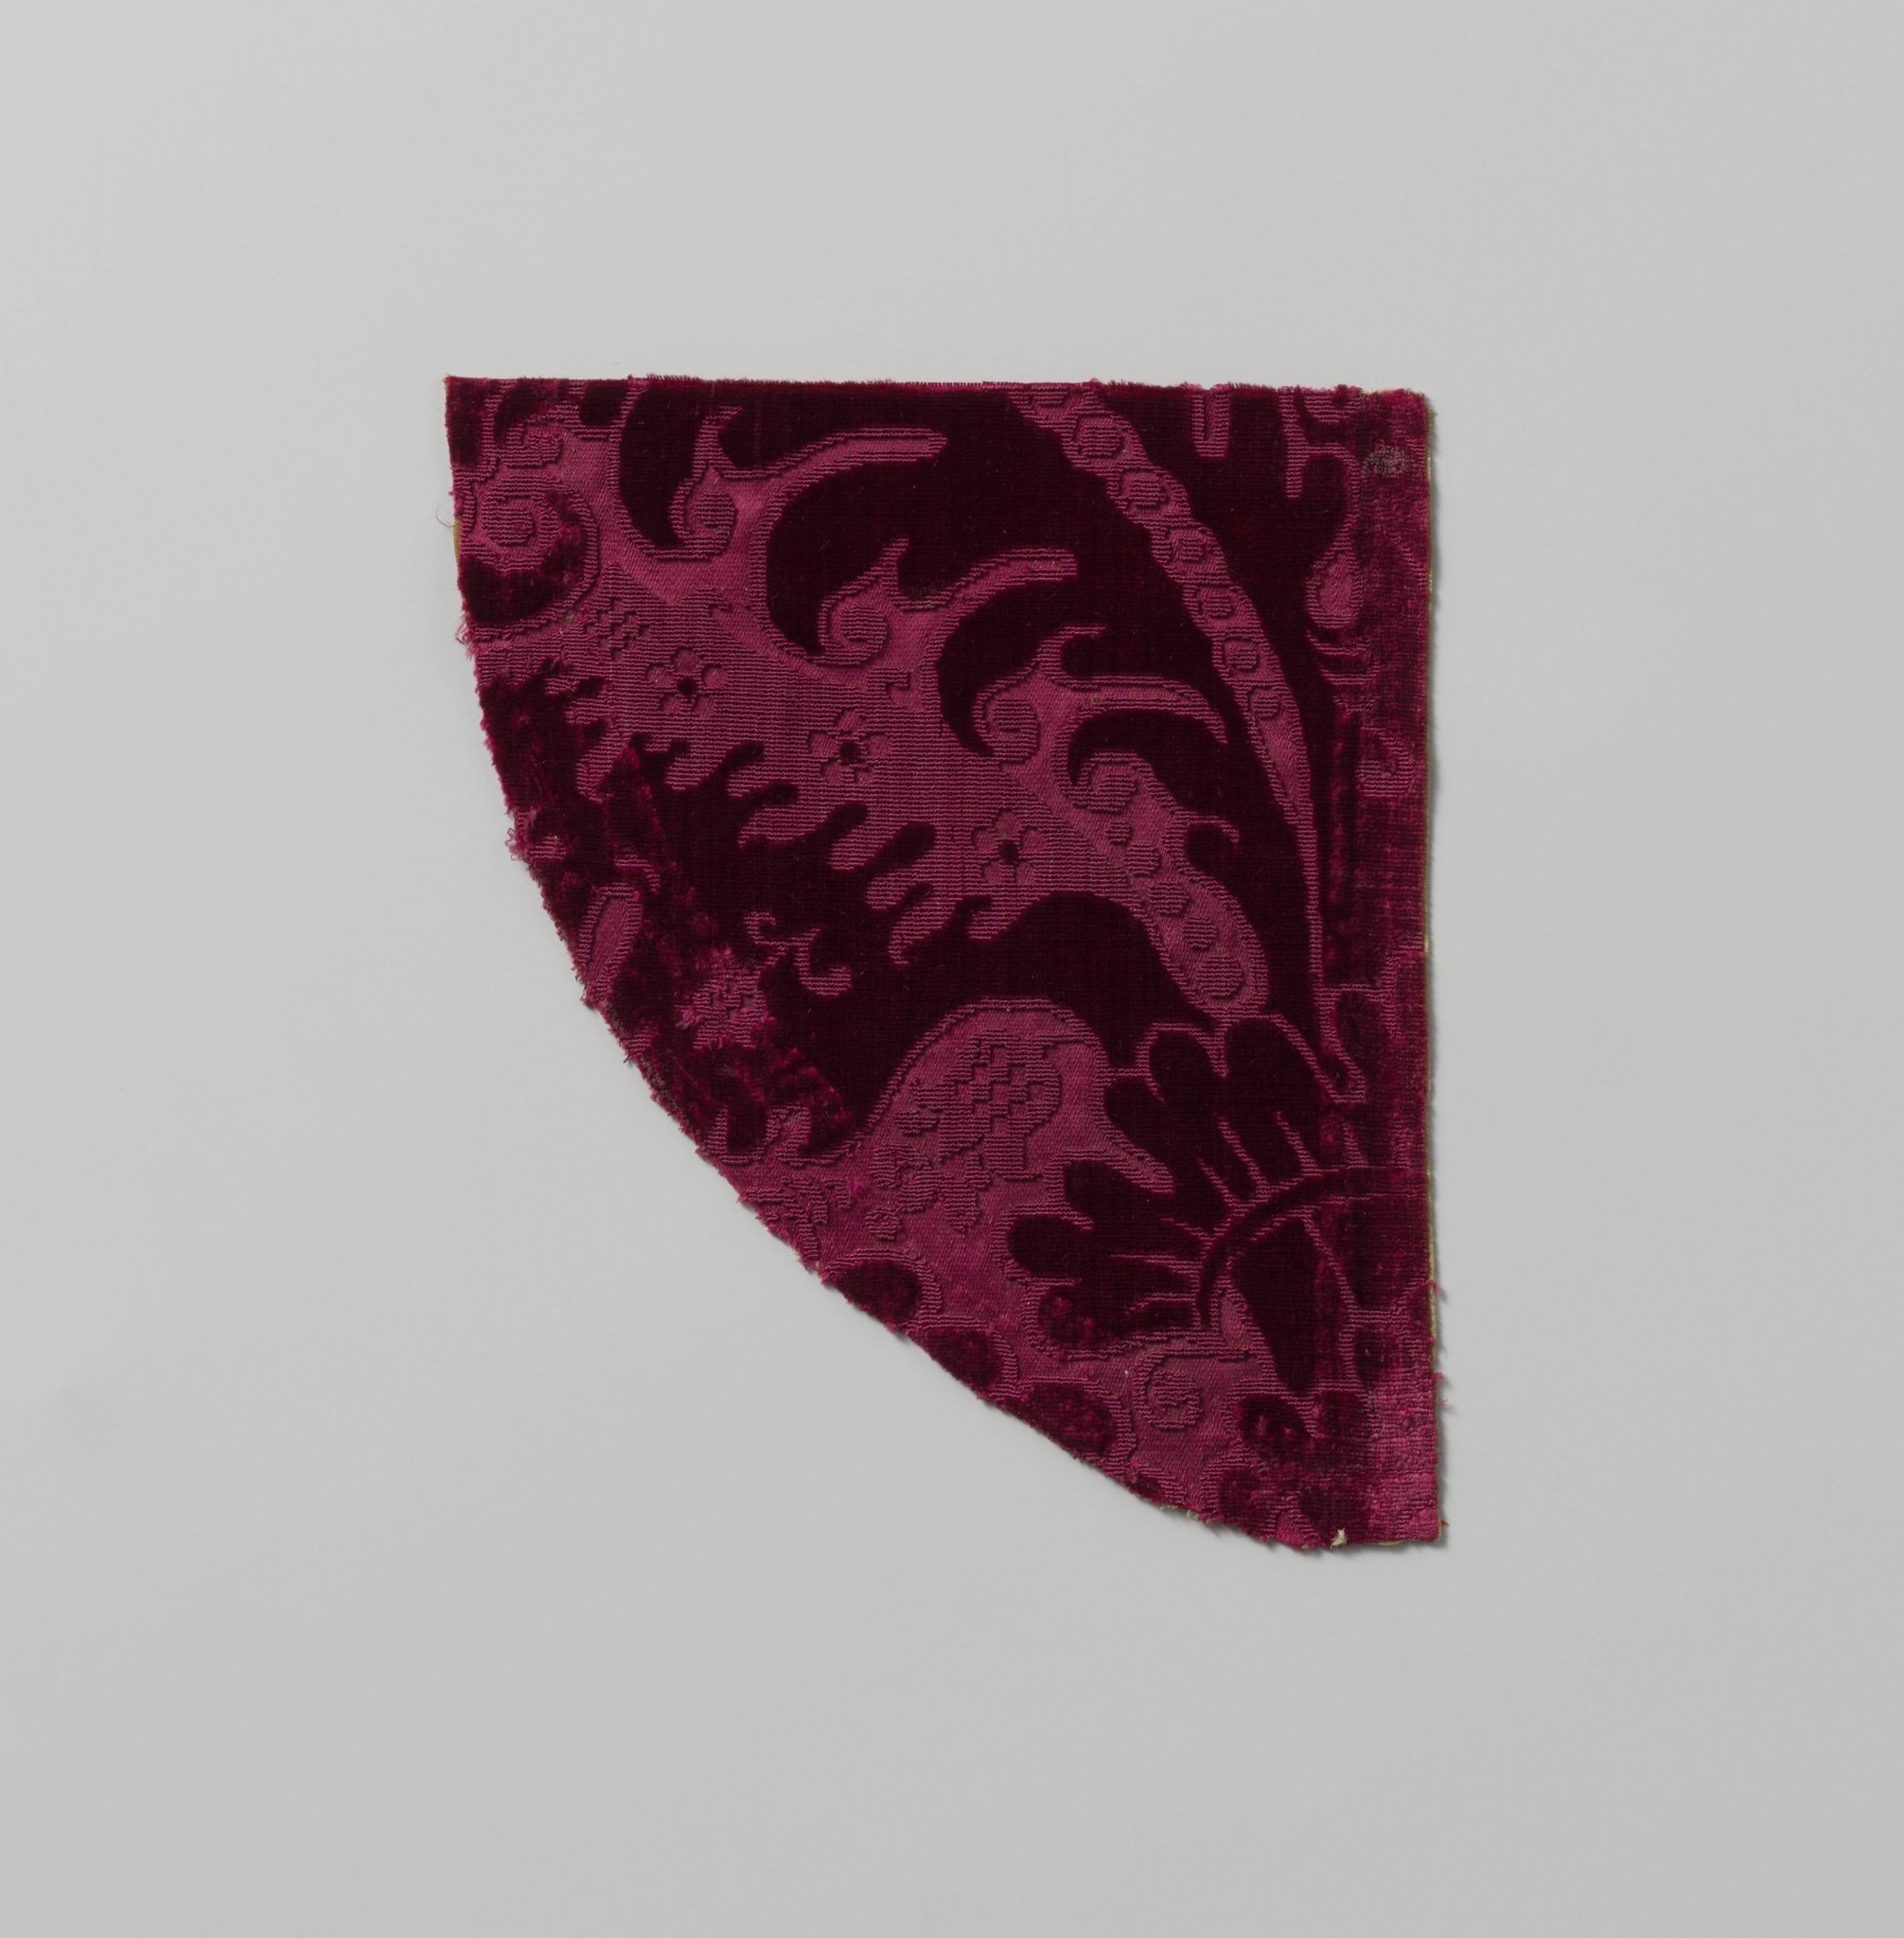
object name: zijdefluweel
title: Fragment rode zijdefluweel en satijn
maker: Anonymous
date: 1700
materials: silk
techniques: velvet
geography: france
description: Fragment rode zijde fluweel en satijn. Het patroon heeft grote gestileerde bladeren waarin kleine bloemen en waartussen bloemtakken.